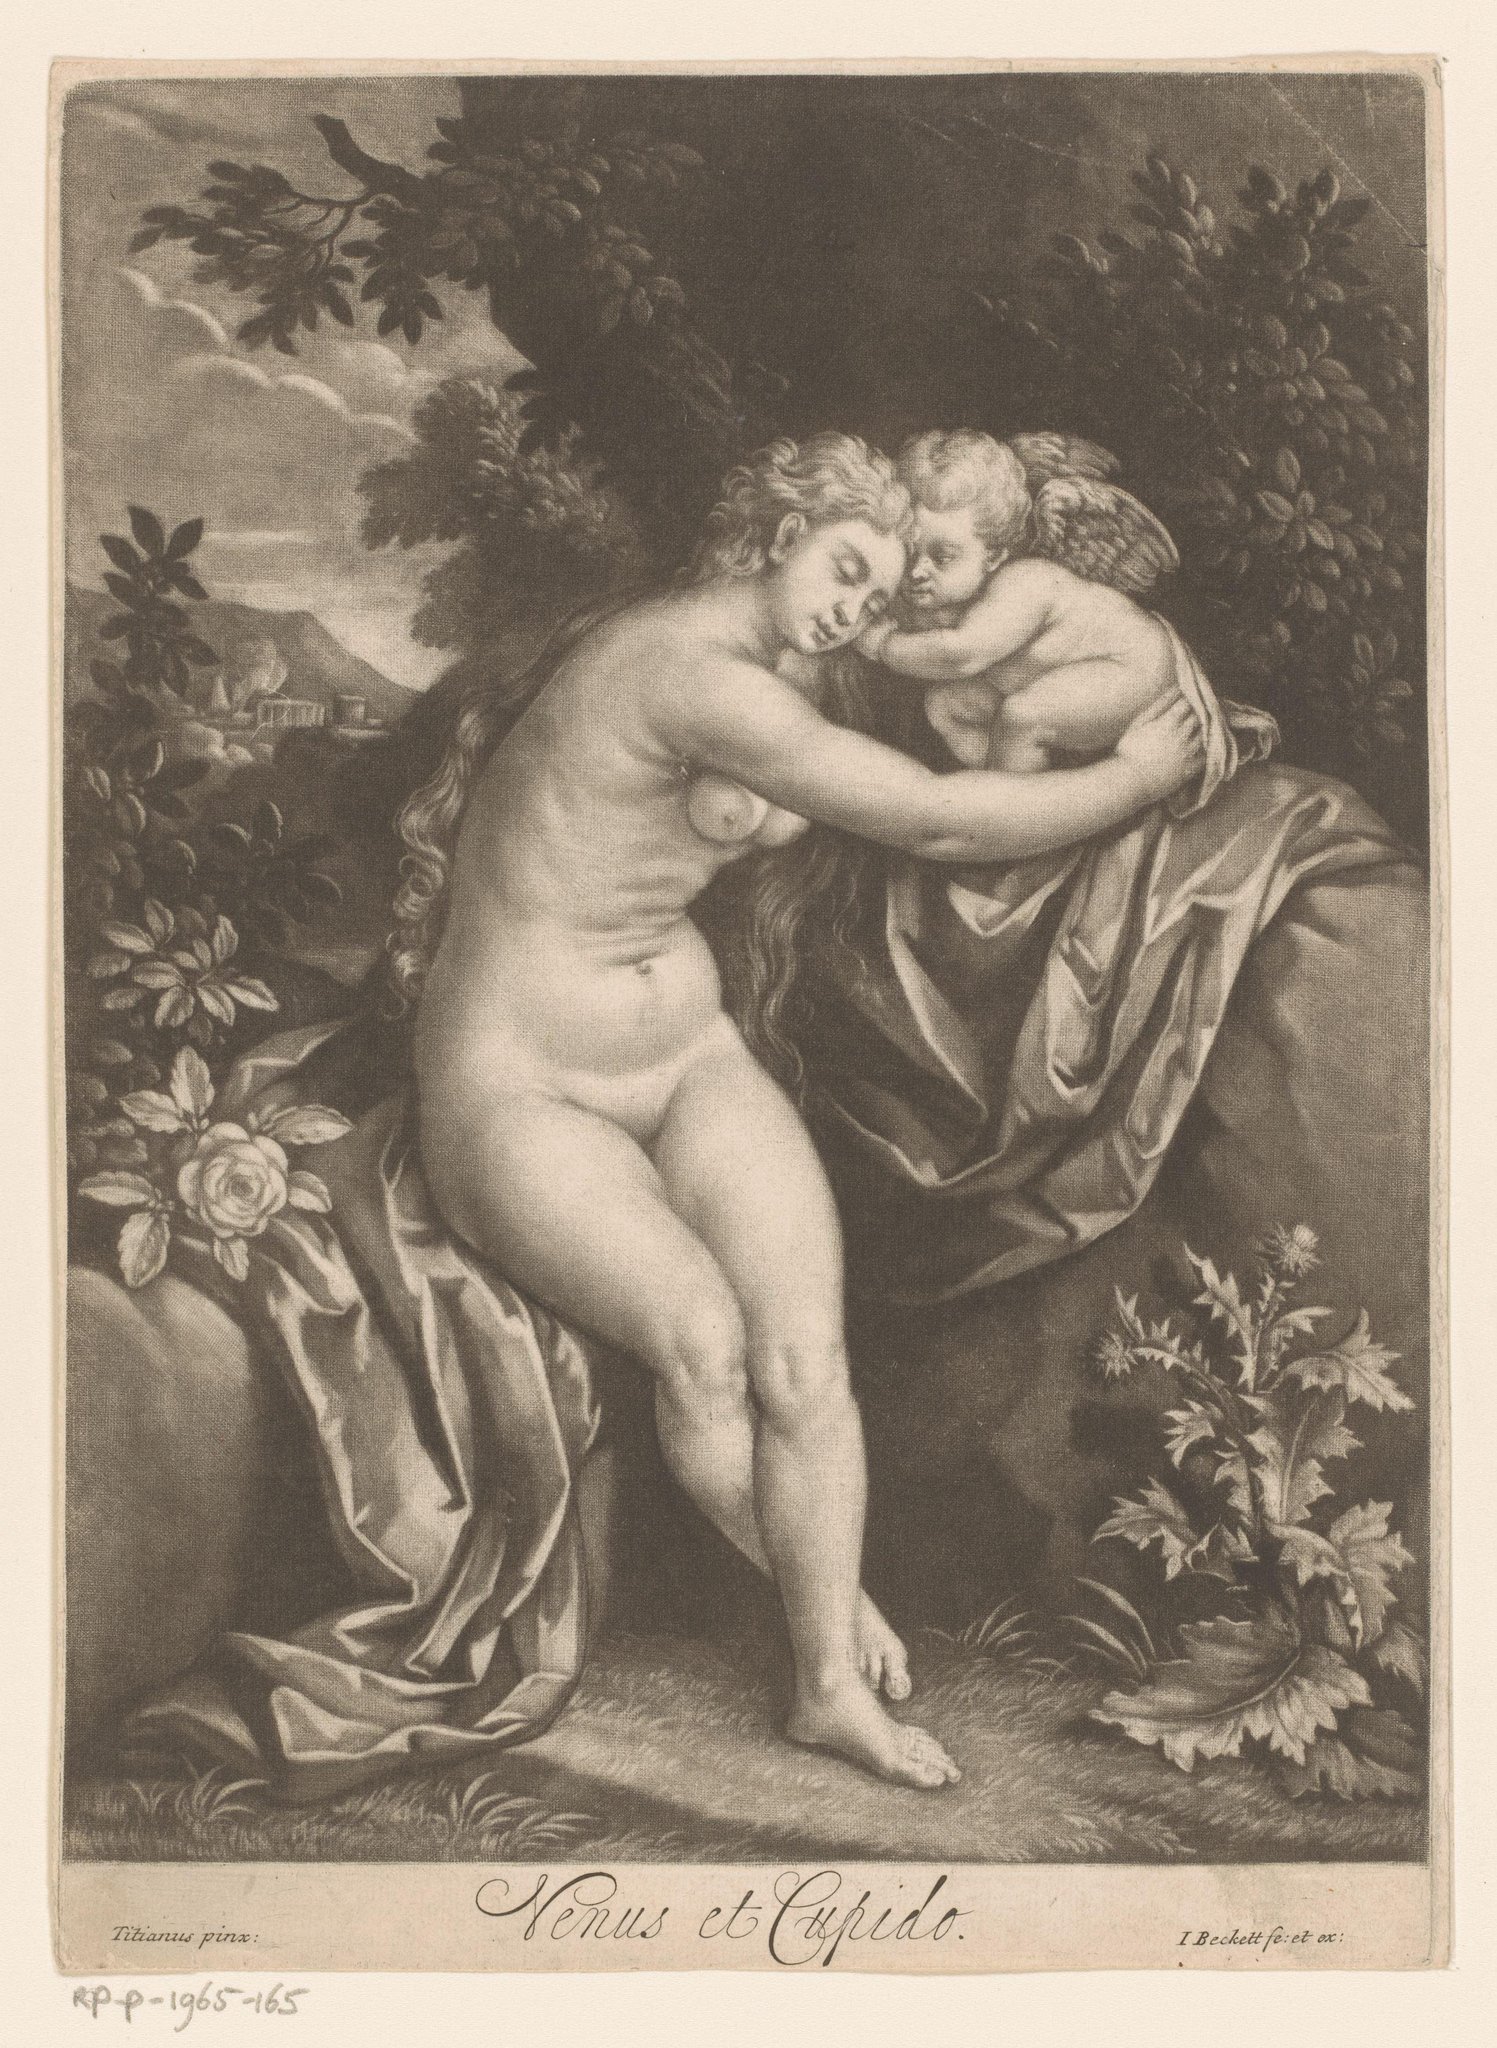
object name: print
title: Venus en Cupido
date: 1681-1688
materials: paper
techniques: mezzotint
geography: london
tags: venus and cupid (cupid not being mere attribute)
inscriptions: collector's mark: Lugt 2228